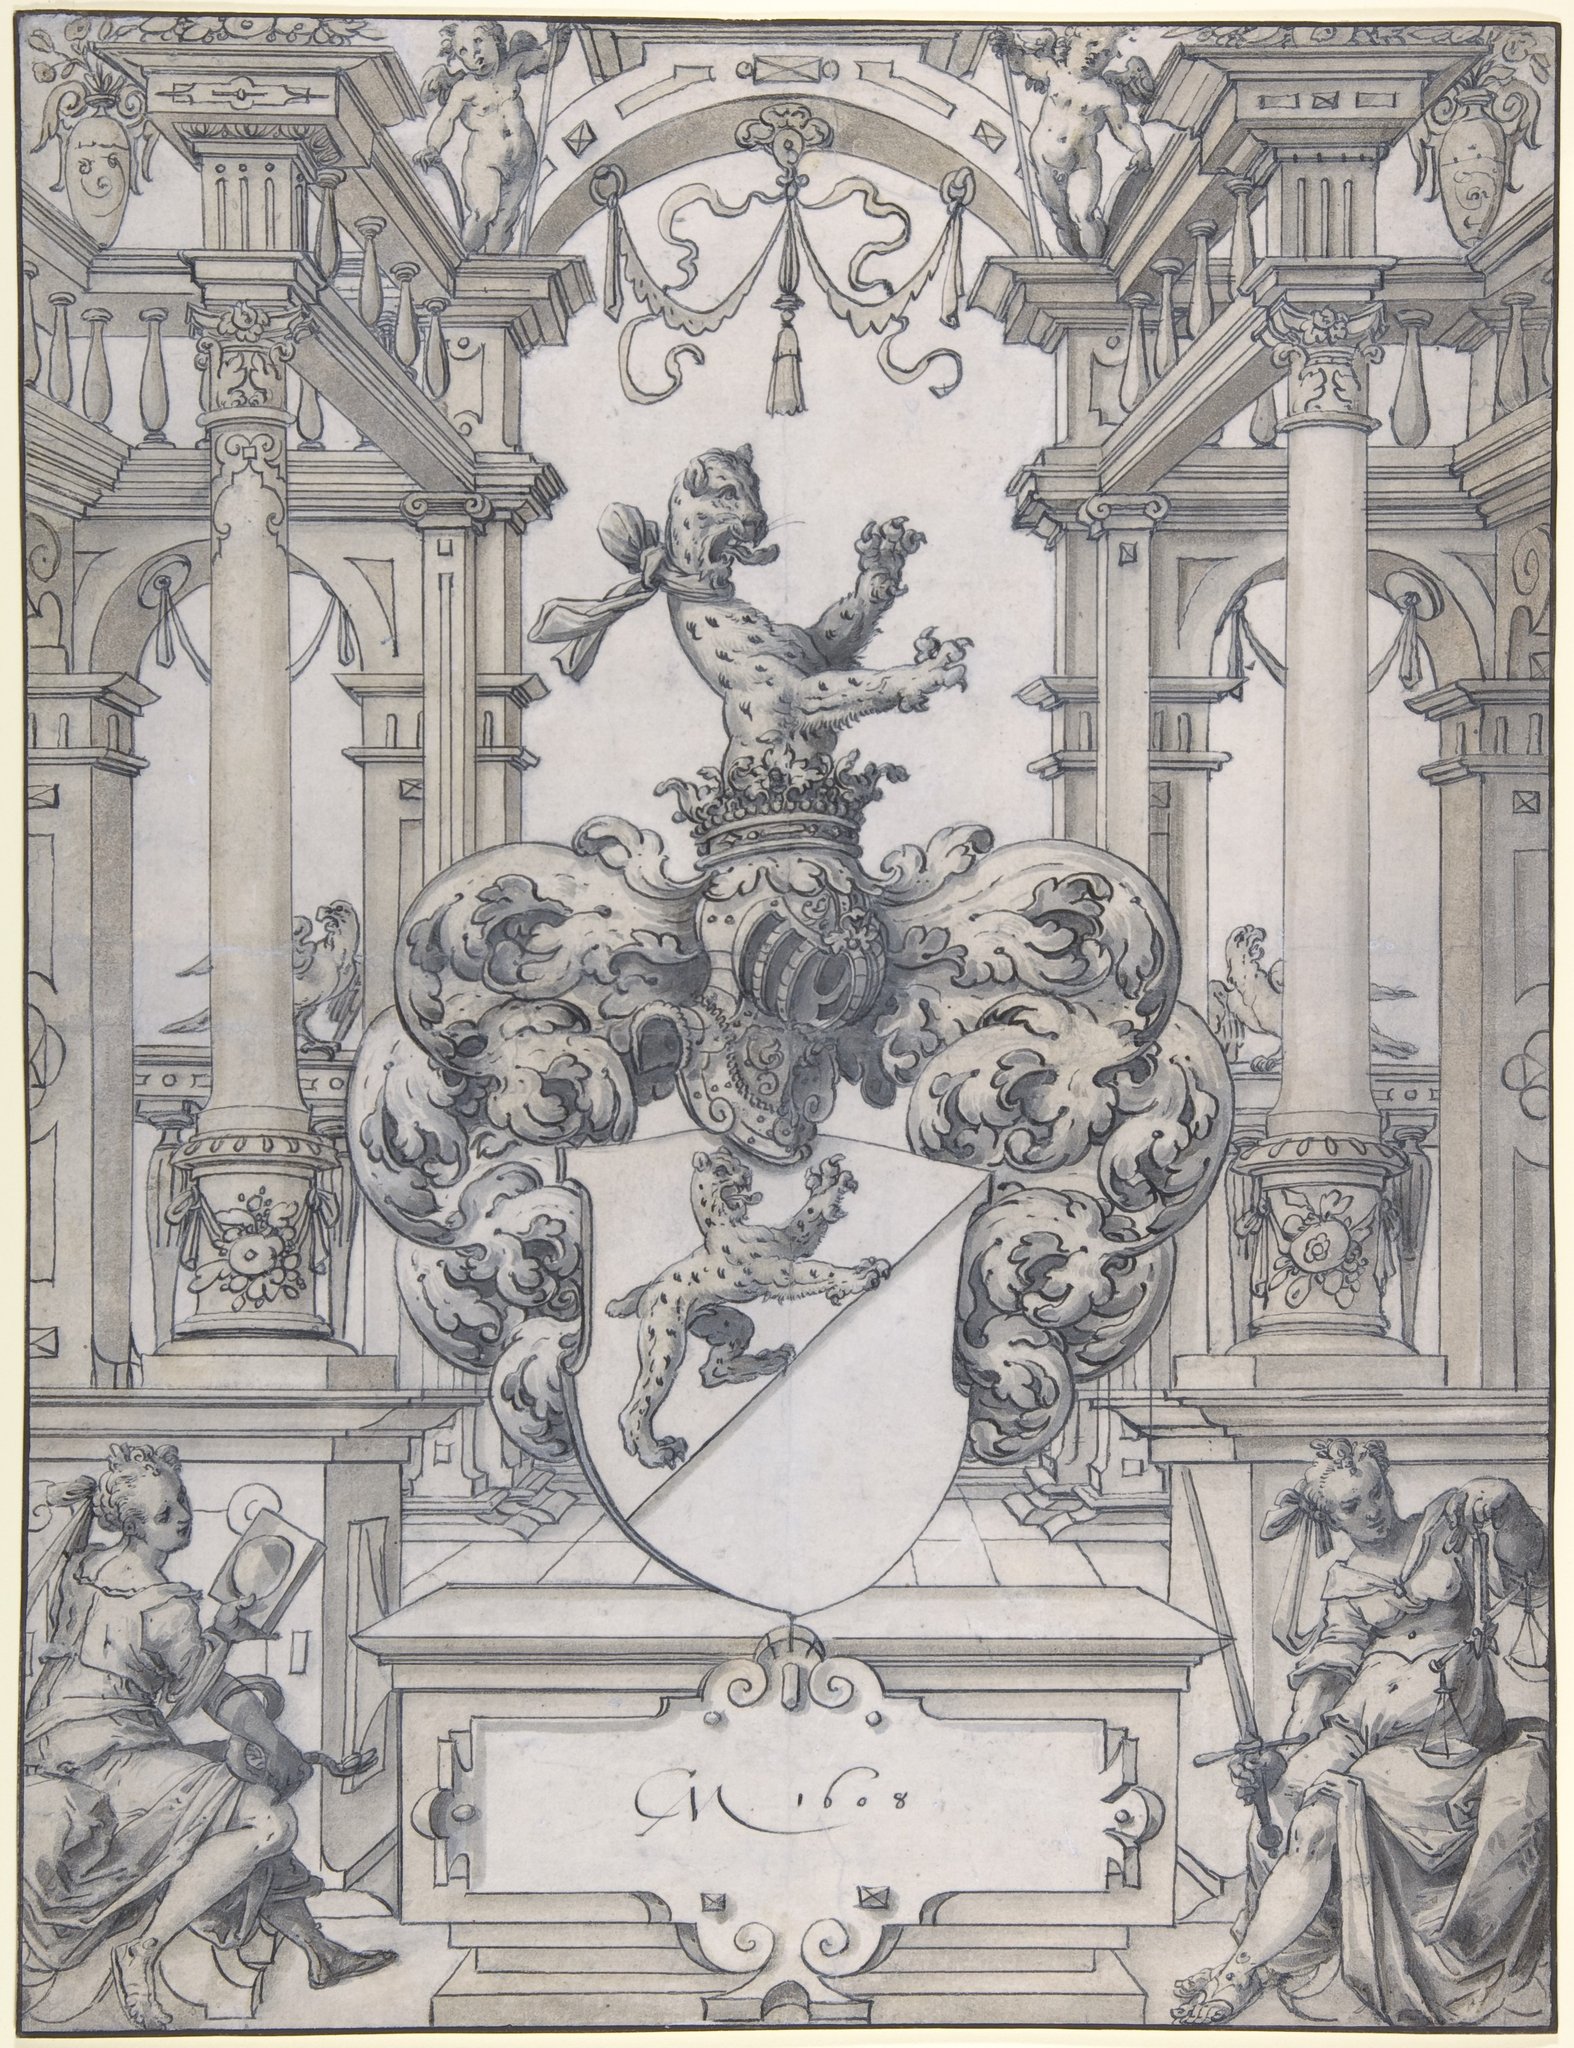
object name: collection ornament architecture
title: Design for a Stained Glass Window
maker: christoph murer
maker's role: artist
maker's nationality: swiss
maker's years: 1558-1614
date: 1608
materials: ink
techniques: pen, wash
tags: animals,women,coat of arms